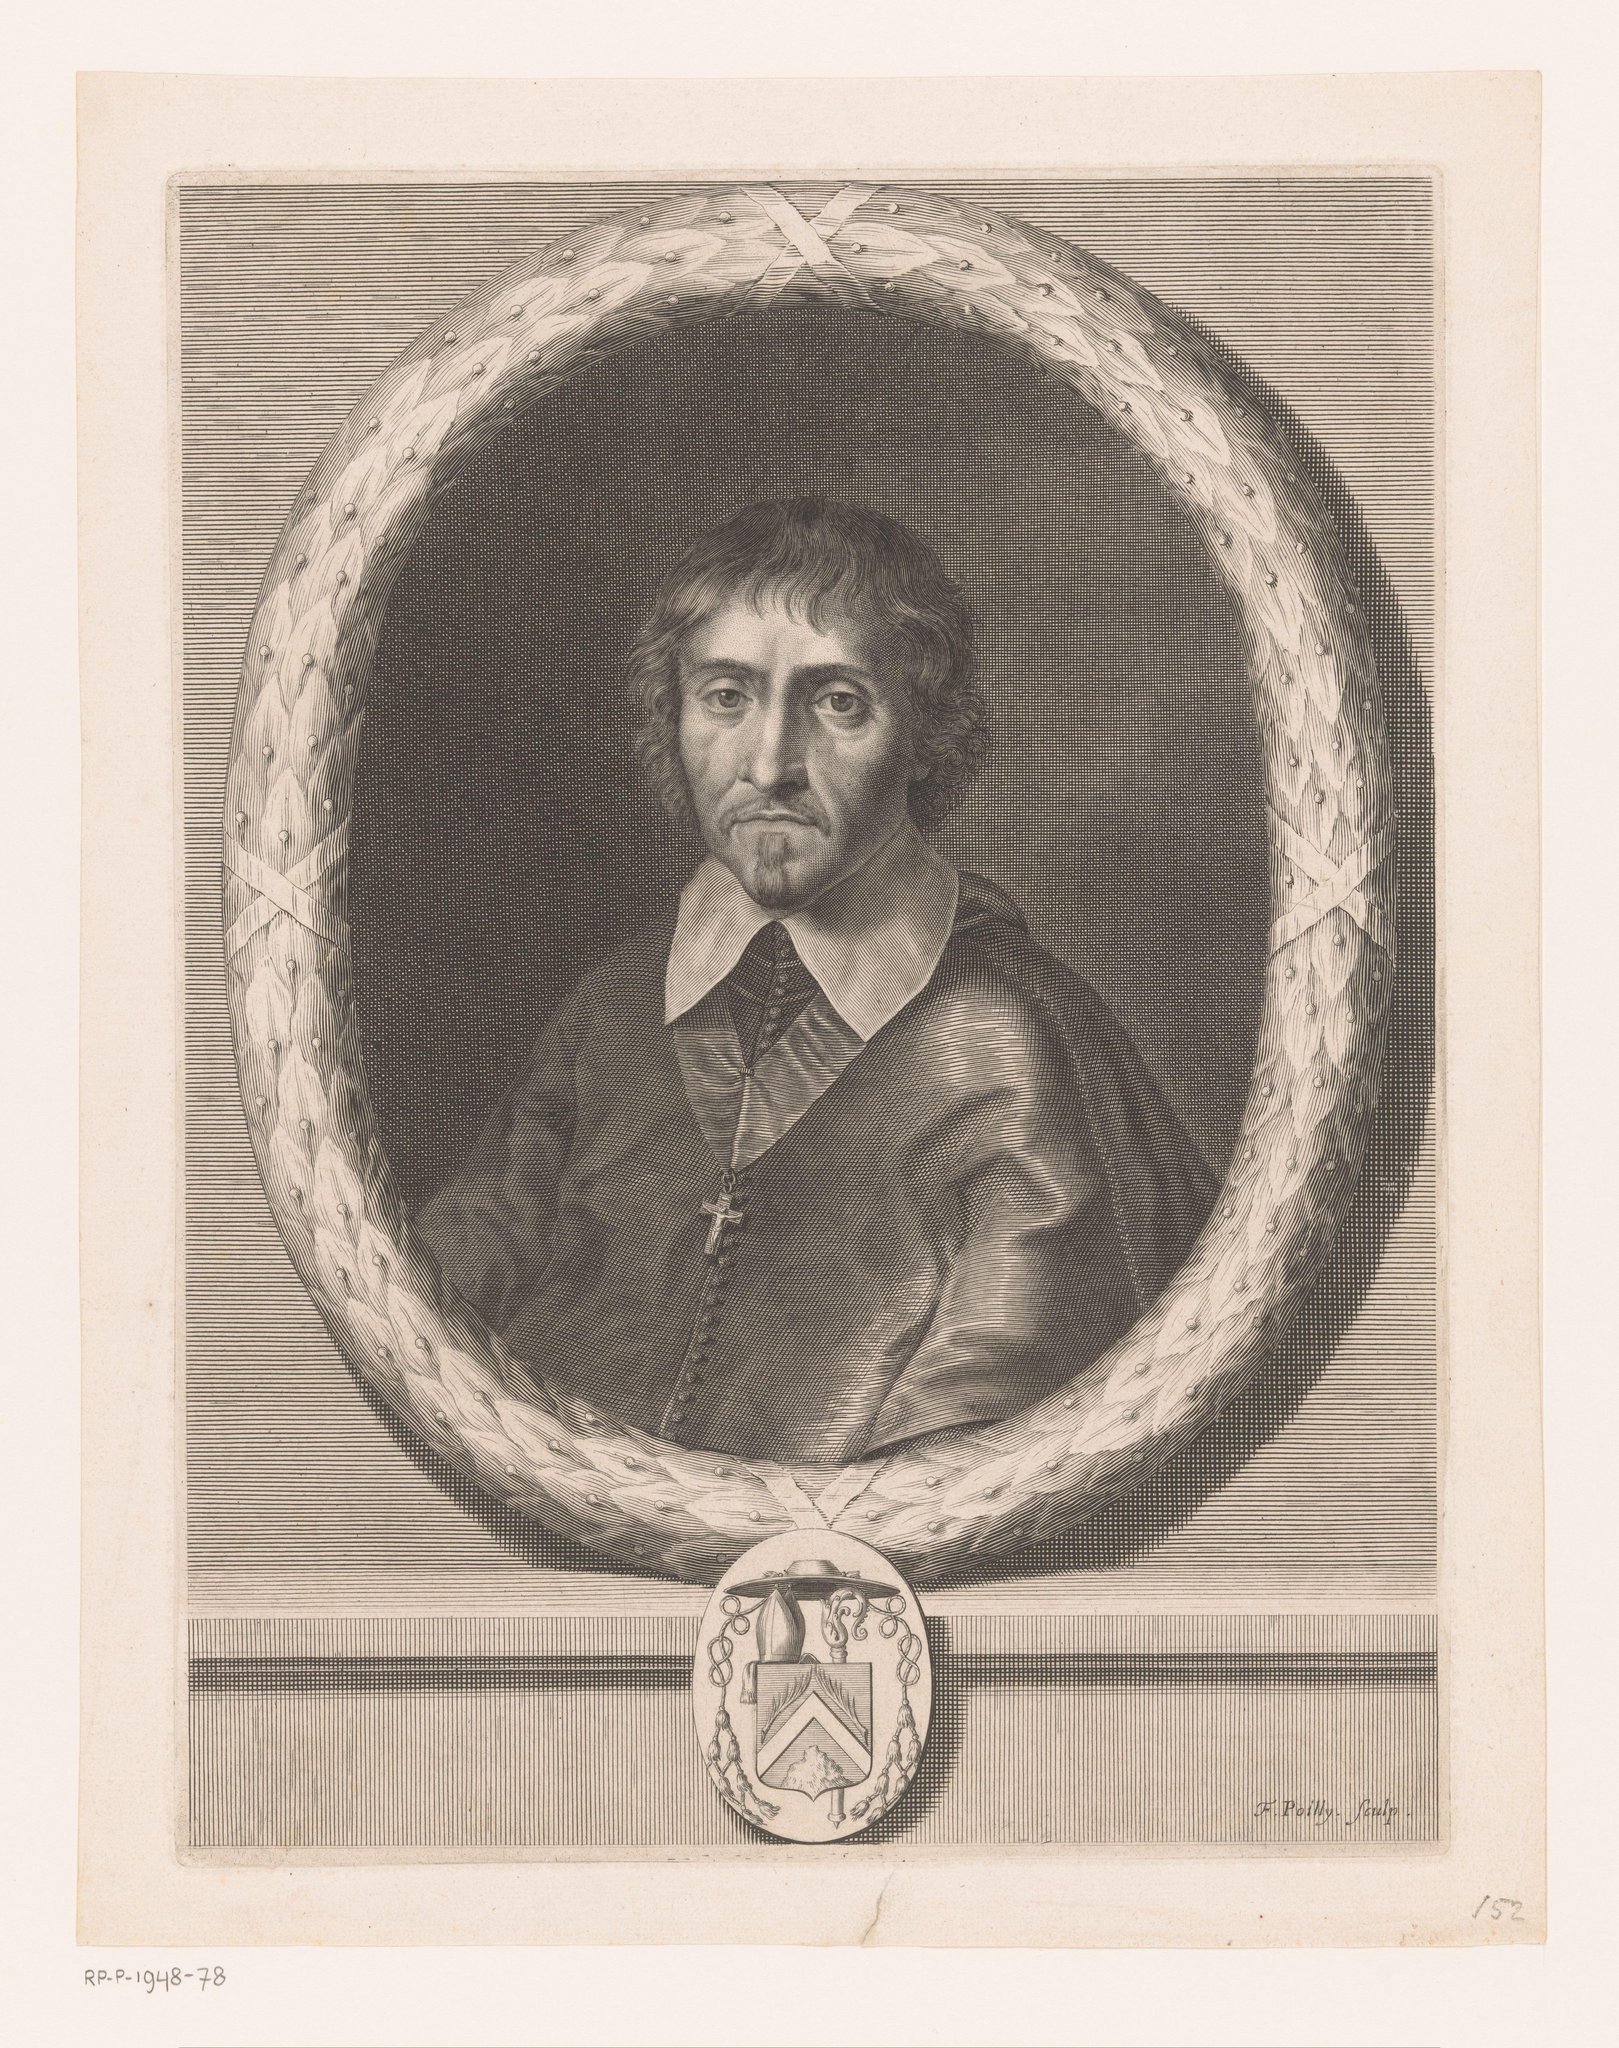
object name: print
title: Portret van Henri Arnaud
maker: françois de poilly (i)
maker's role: print maker, publisher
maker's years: 1622-1693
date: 1632-1693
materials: paper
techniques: engraving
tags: archbishop, bishop, etc. (roman catholic), historical persons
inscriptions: collector's mark: Lugt 2228